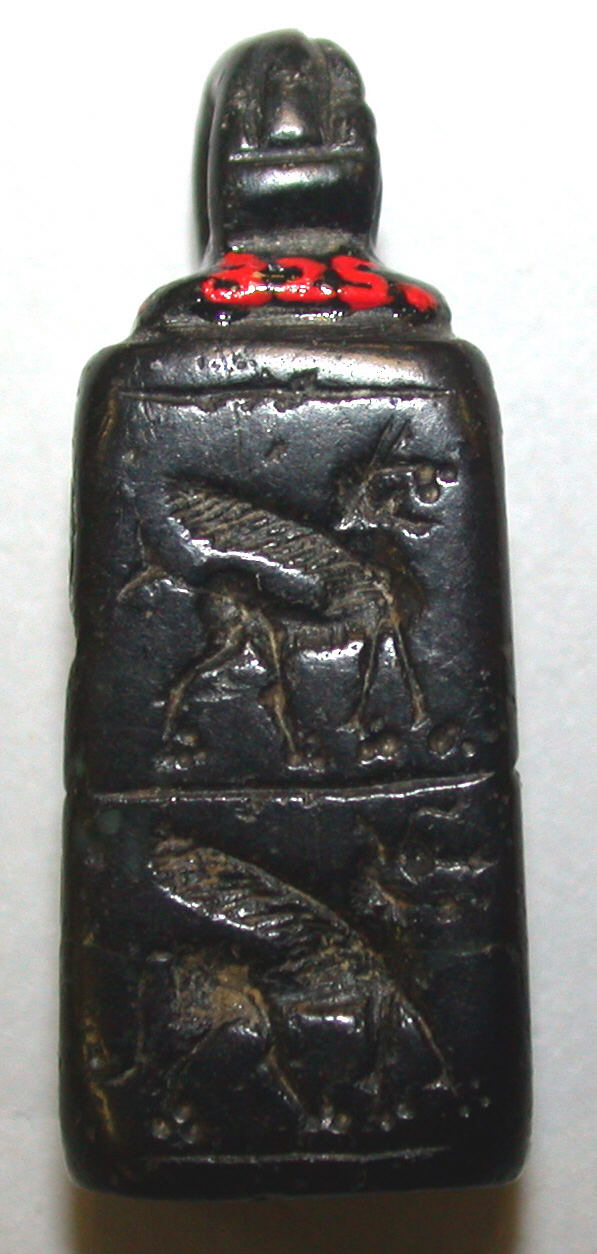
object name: stamp seal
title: Stamp seal (cubical with loop handle) with monsters and anthropomorphic figure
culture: urartian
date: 900-601 BCE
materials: stone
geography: mesopotamia